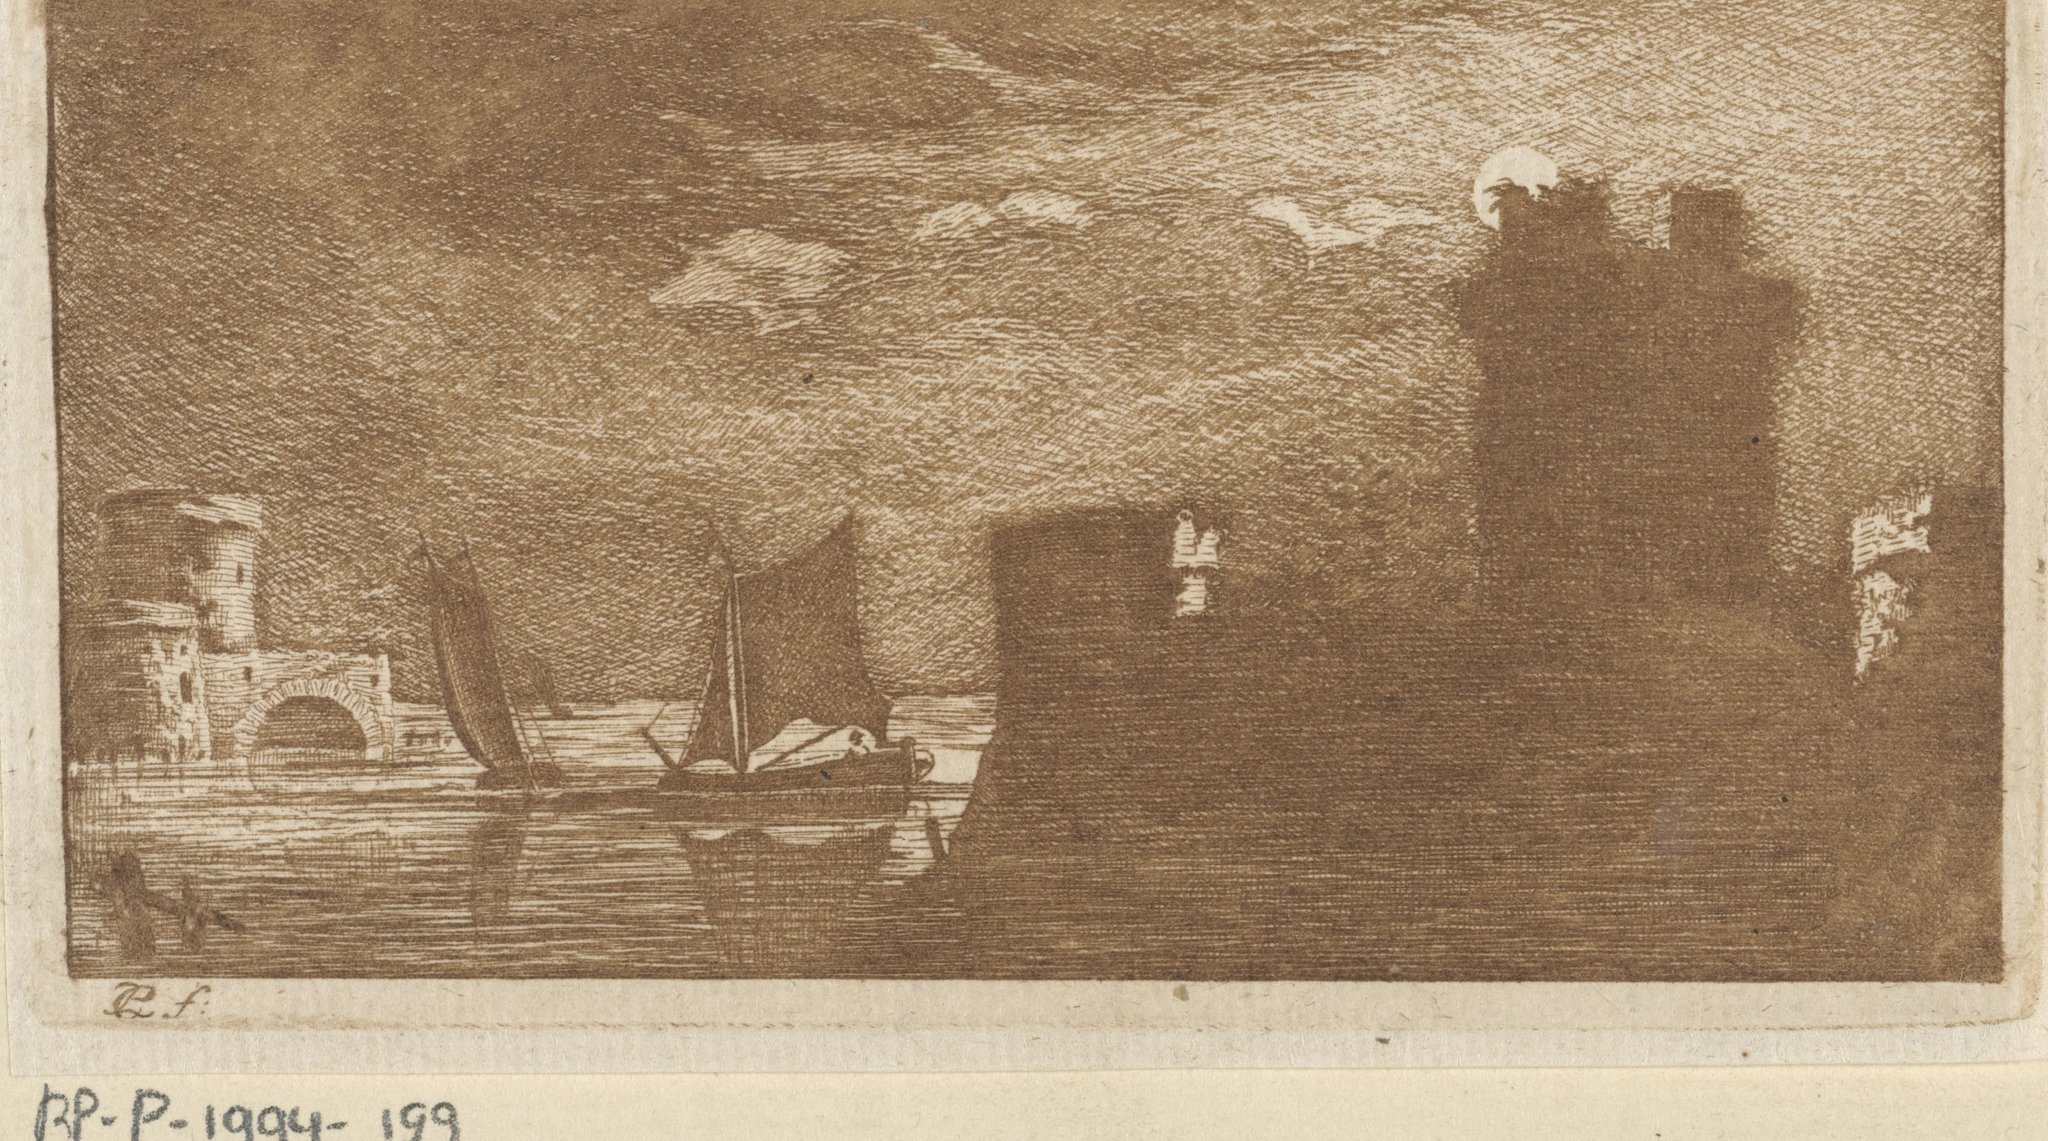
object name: print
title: Riviergezicht bij nacht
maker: caspar jacobsz. philips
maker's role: draughtsman, print maker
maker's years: 1732-1789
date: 1766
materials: paper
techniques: etching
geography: amsterdam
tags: river, landscape with ruins, night ~ landscape (sometimes titled 'nox')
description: Rivierlandschap met de ruïne van een toren en links op de achtergrond een vesting. Op de rivier een zeilschip.